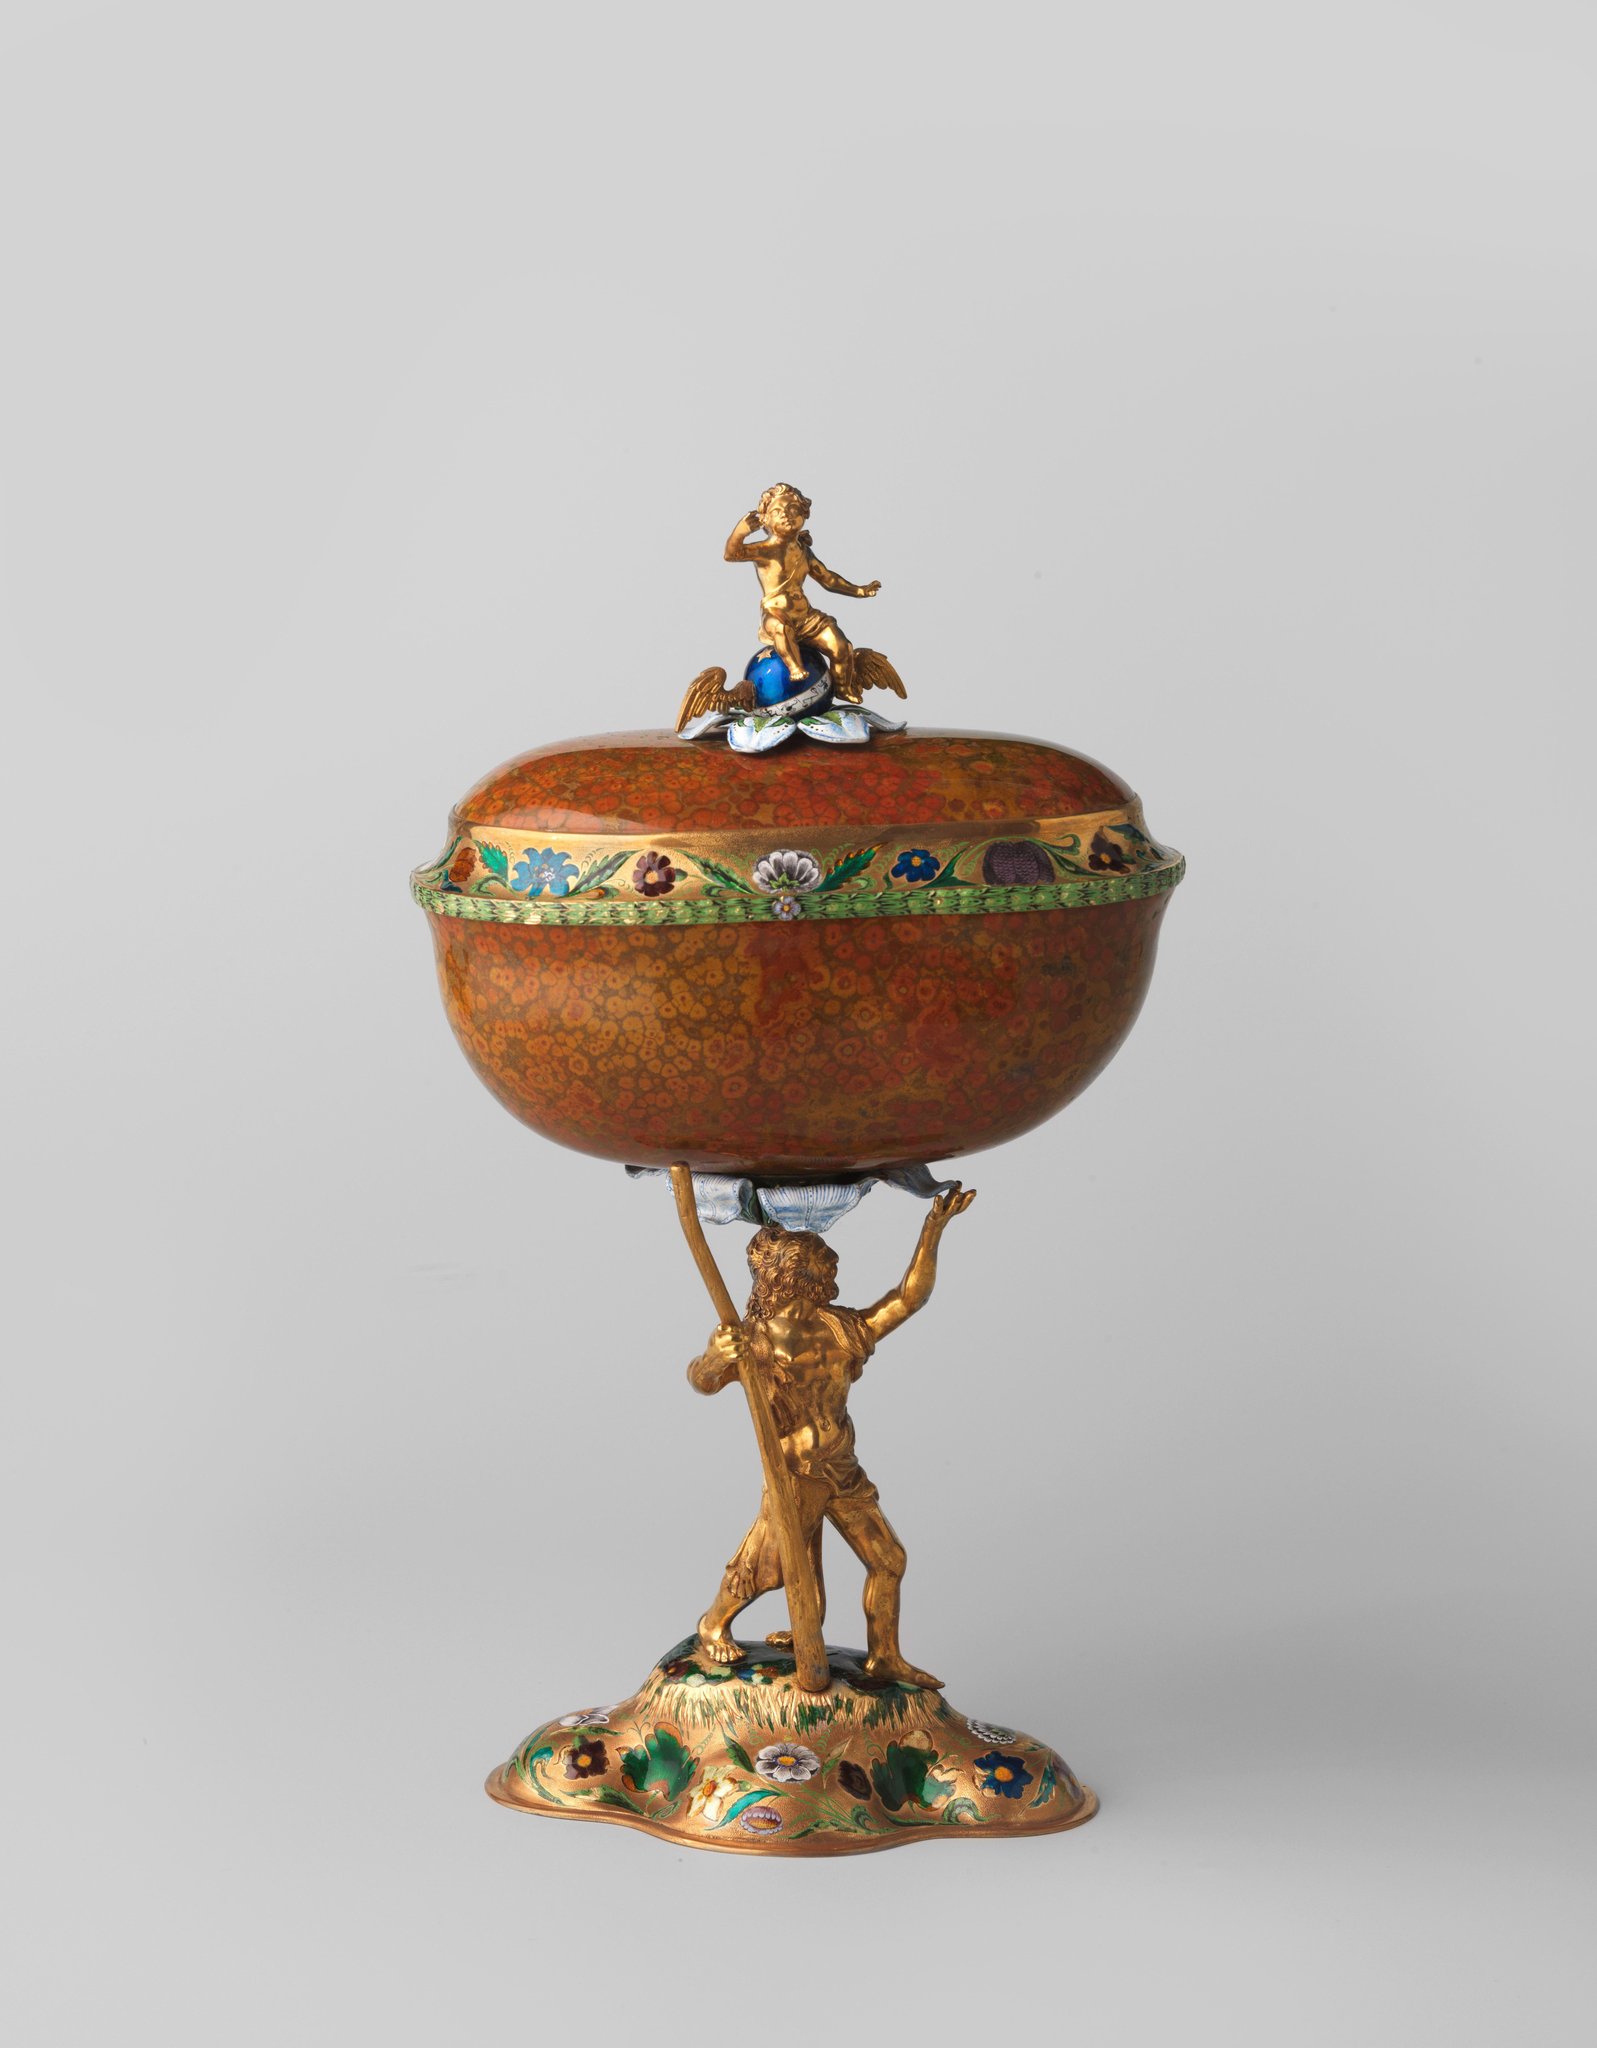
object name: coupe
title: Coupe van rood-bruin gevlekt chalcedoon met voet van goud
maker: Anonymous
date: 1640-1660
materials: stone, gold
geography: eastern europe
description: Coupe, het vat van rood-bruin gevlekt chalcedoon wordt gedragen door een Hercules-figuur, evenals de drielobbige gewelfde voet van goud. Op de voet veelkleurige bloemen in translucide email; onder het vat een geëmailleerde bloem in wit en blauw.